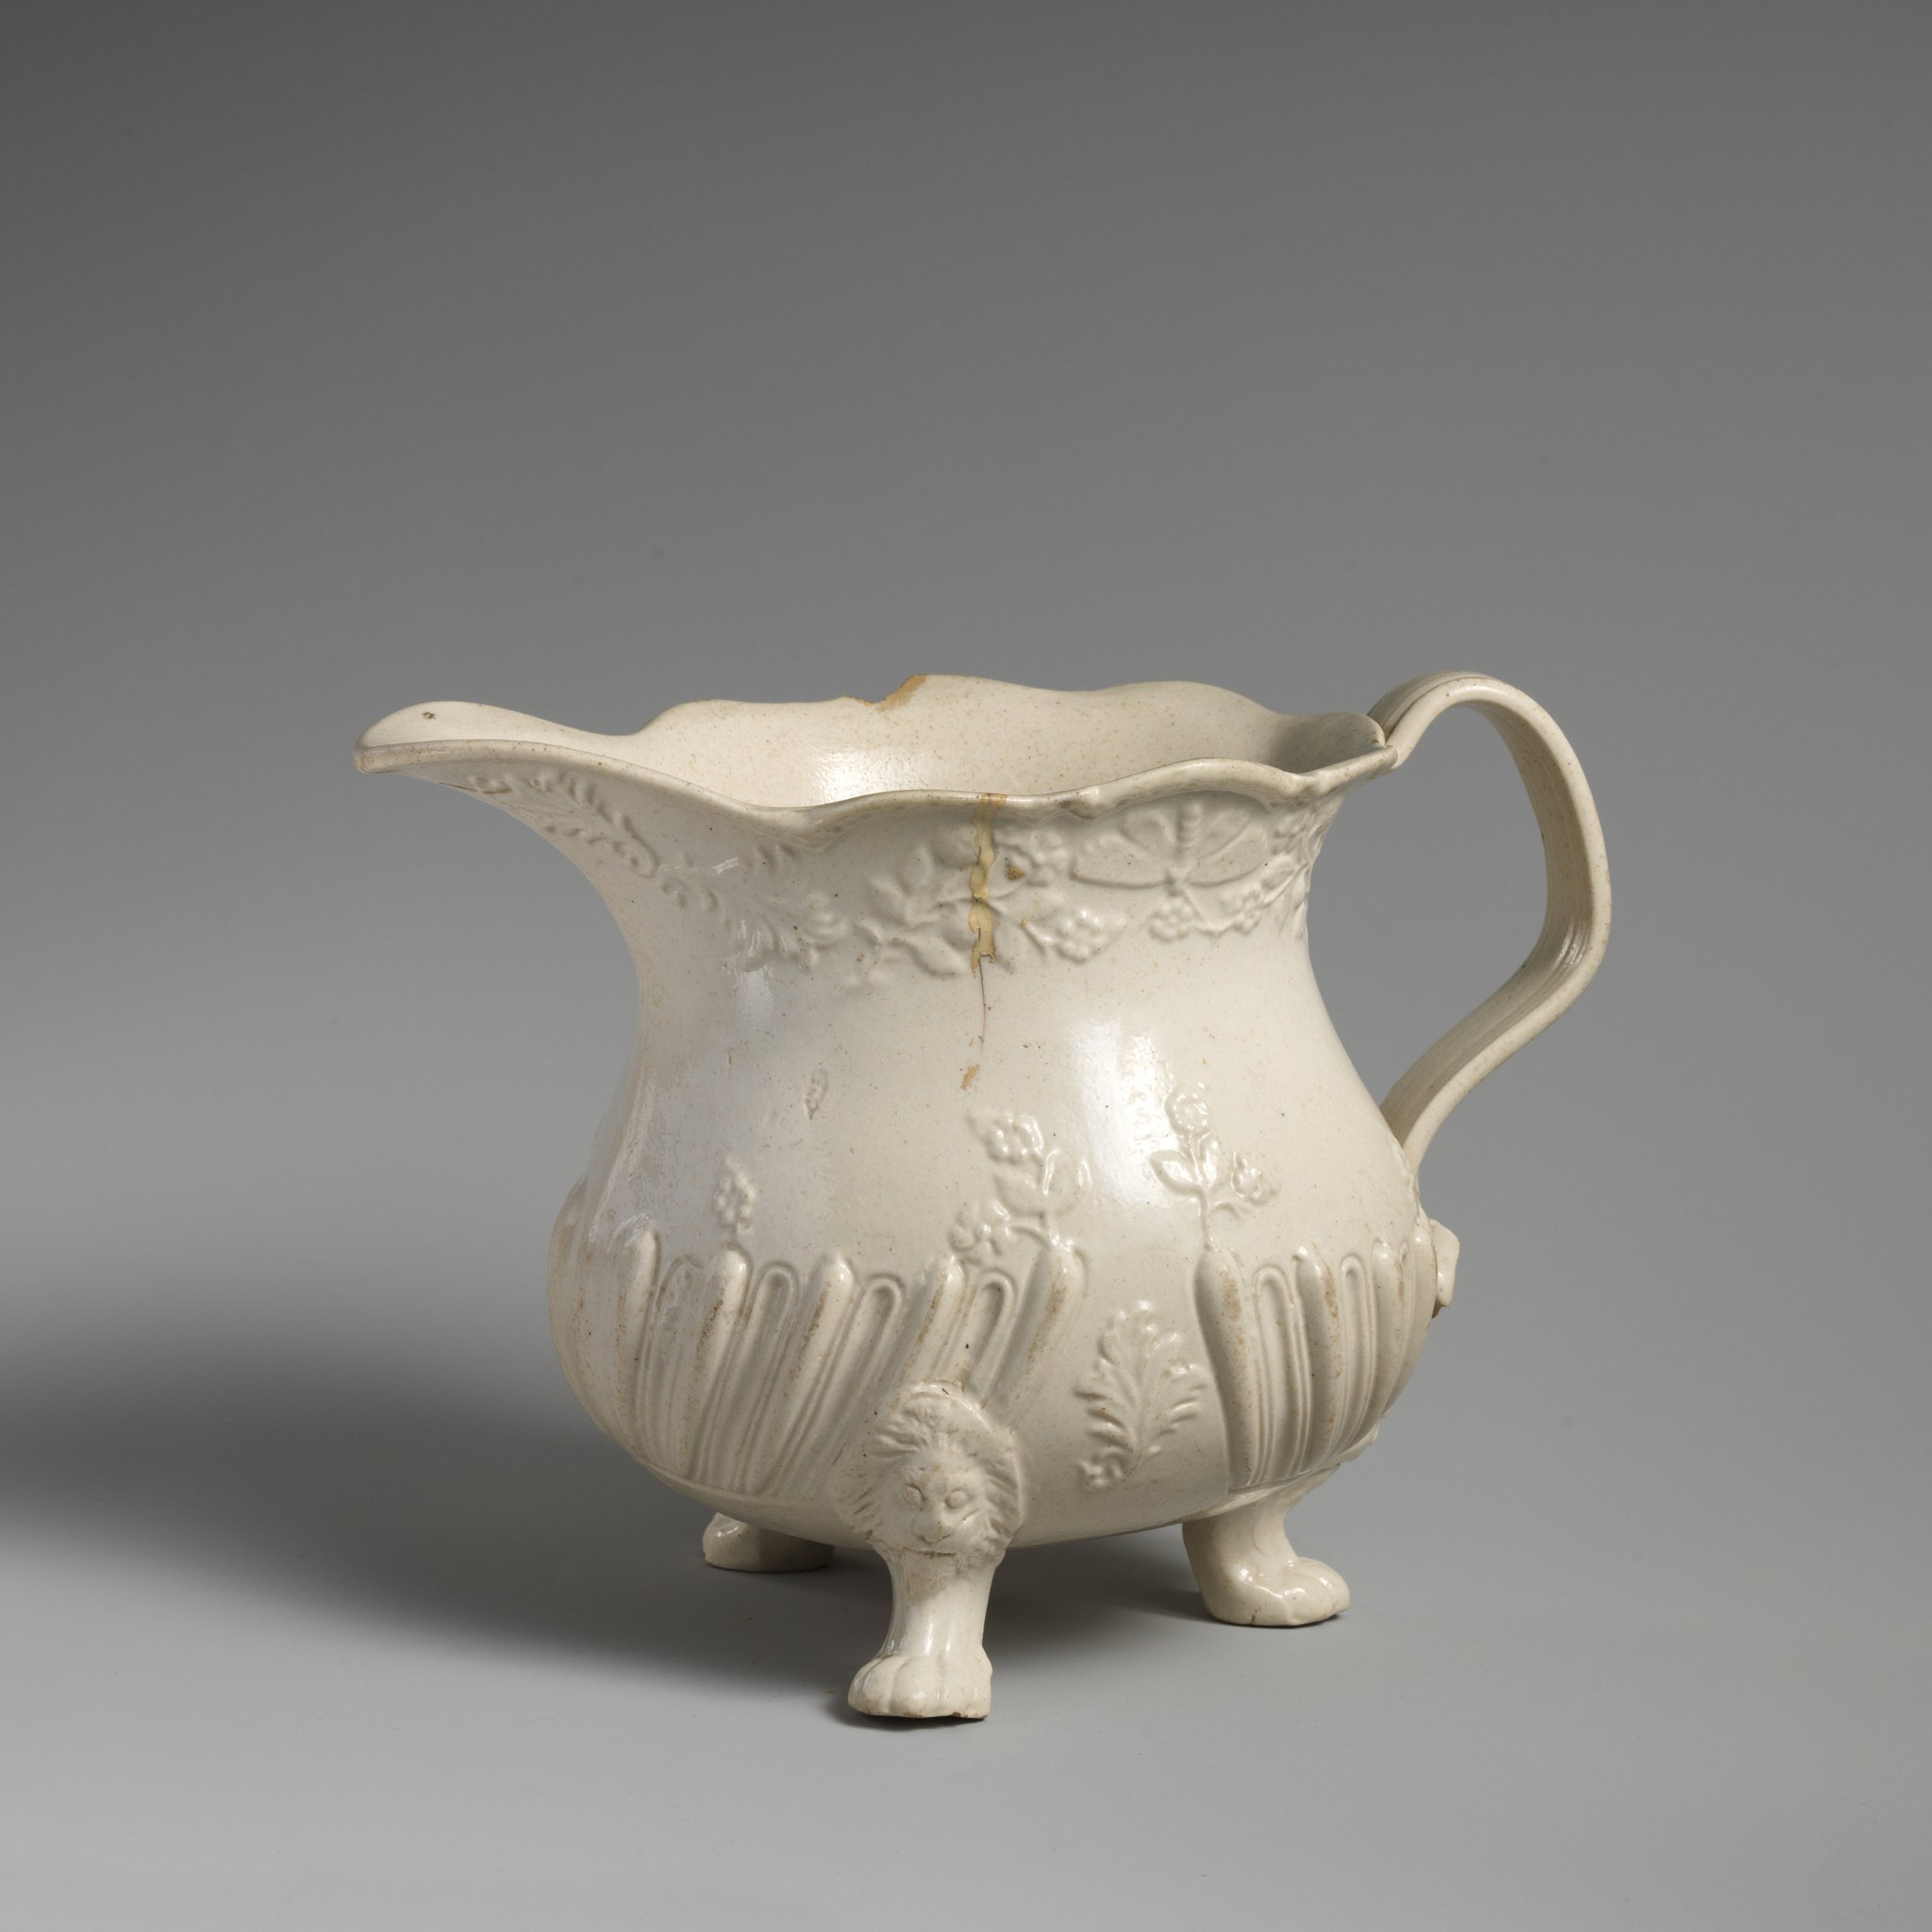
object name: jug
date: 1750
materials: stoneware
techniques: salt glaze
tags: flowers